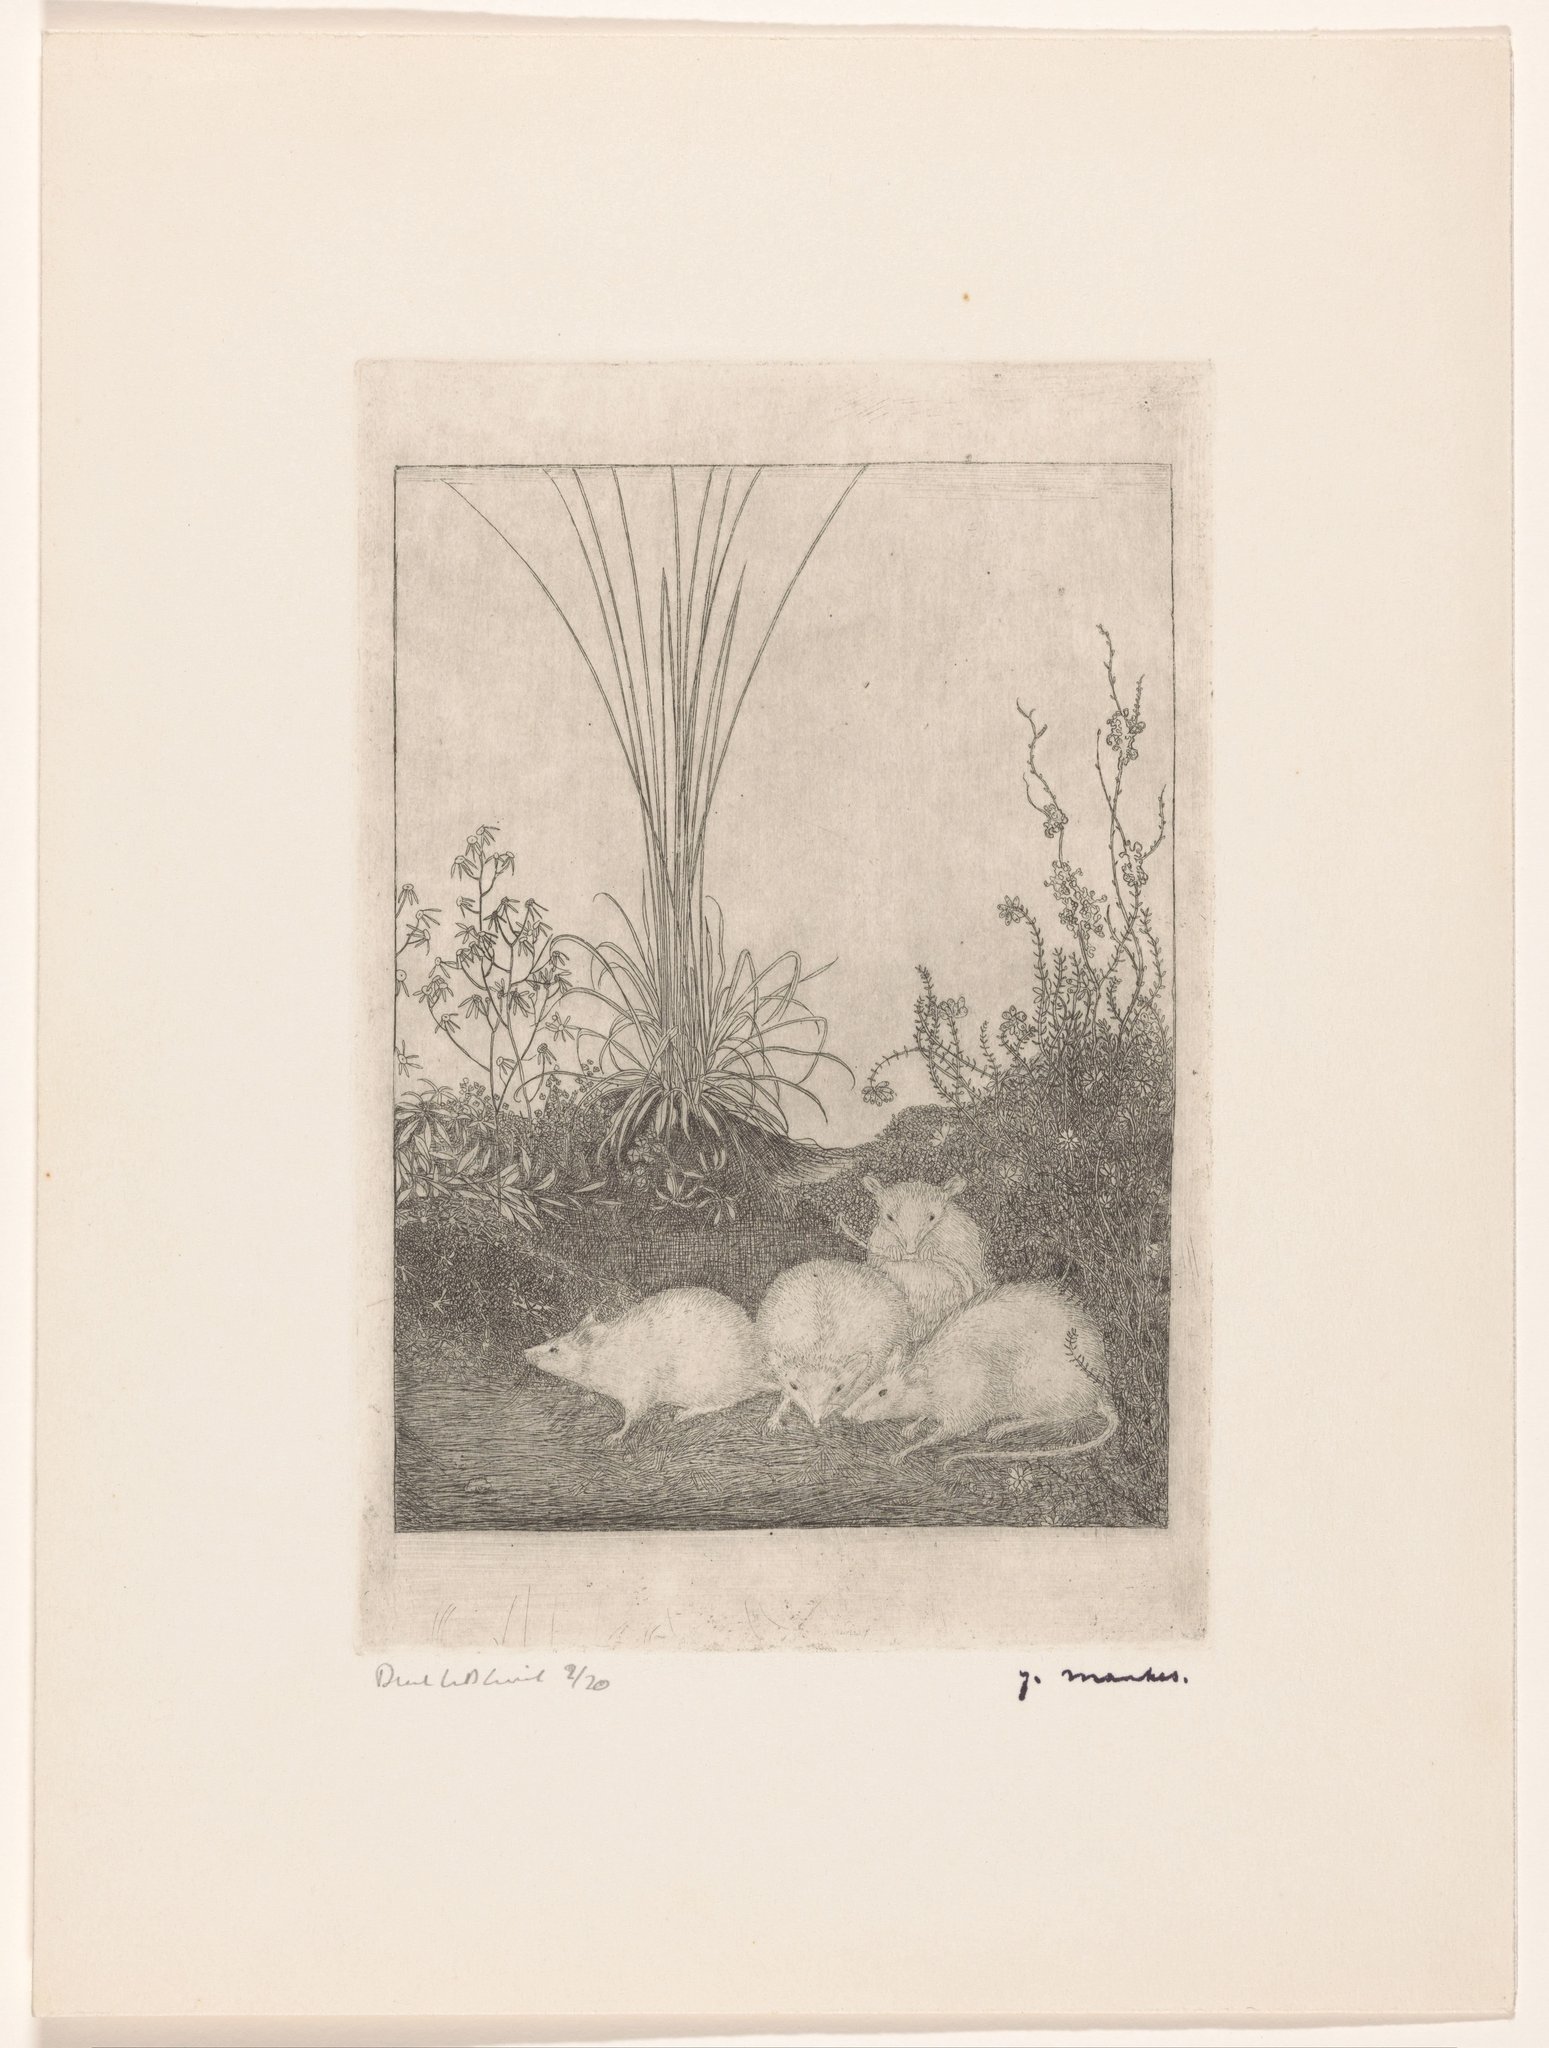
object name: print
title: Vier muizen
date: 1913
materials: ink, paper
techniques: etching, intaglio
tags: rodents: mouse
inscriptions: inscription: ‘J. Mankes.’, signature: ‘Druk WD Kuik 2/20’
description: Herdruk door Dirkje Kuik (1968) van de originele etsplaat van Jan Mankes (1913). De huidige titel is door het museum toegekend bij gebrek aan informatie over een originele titel.